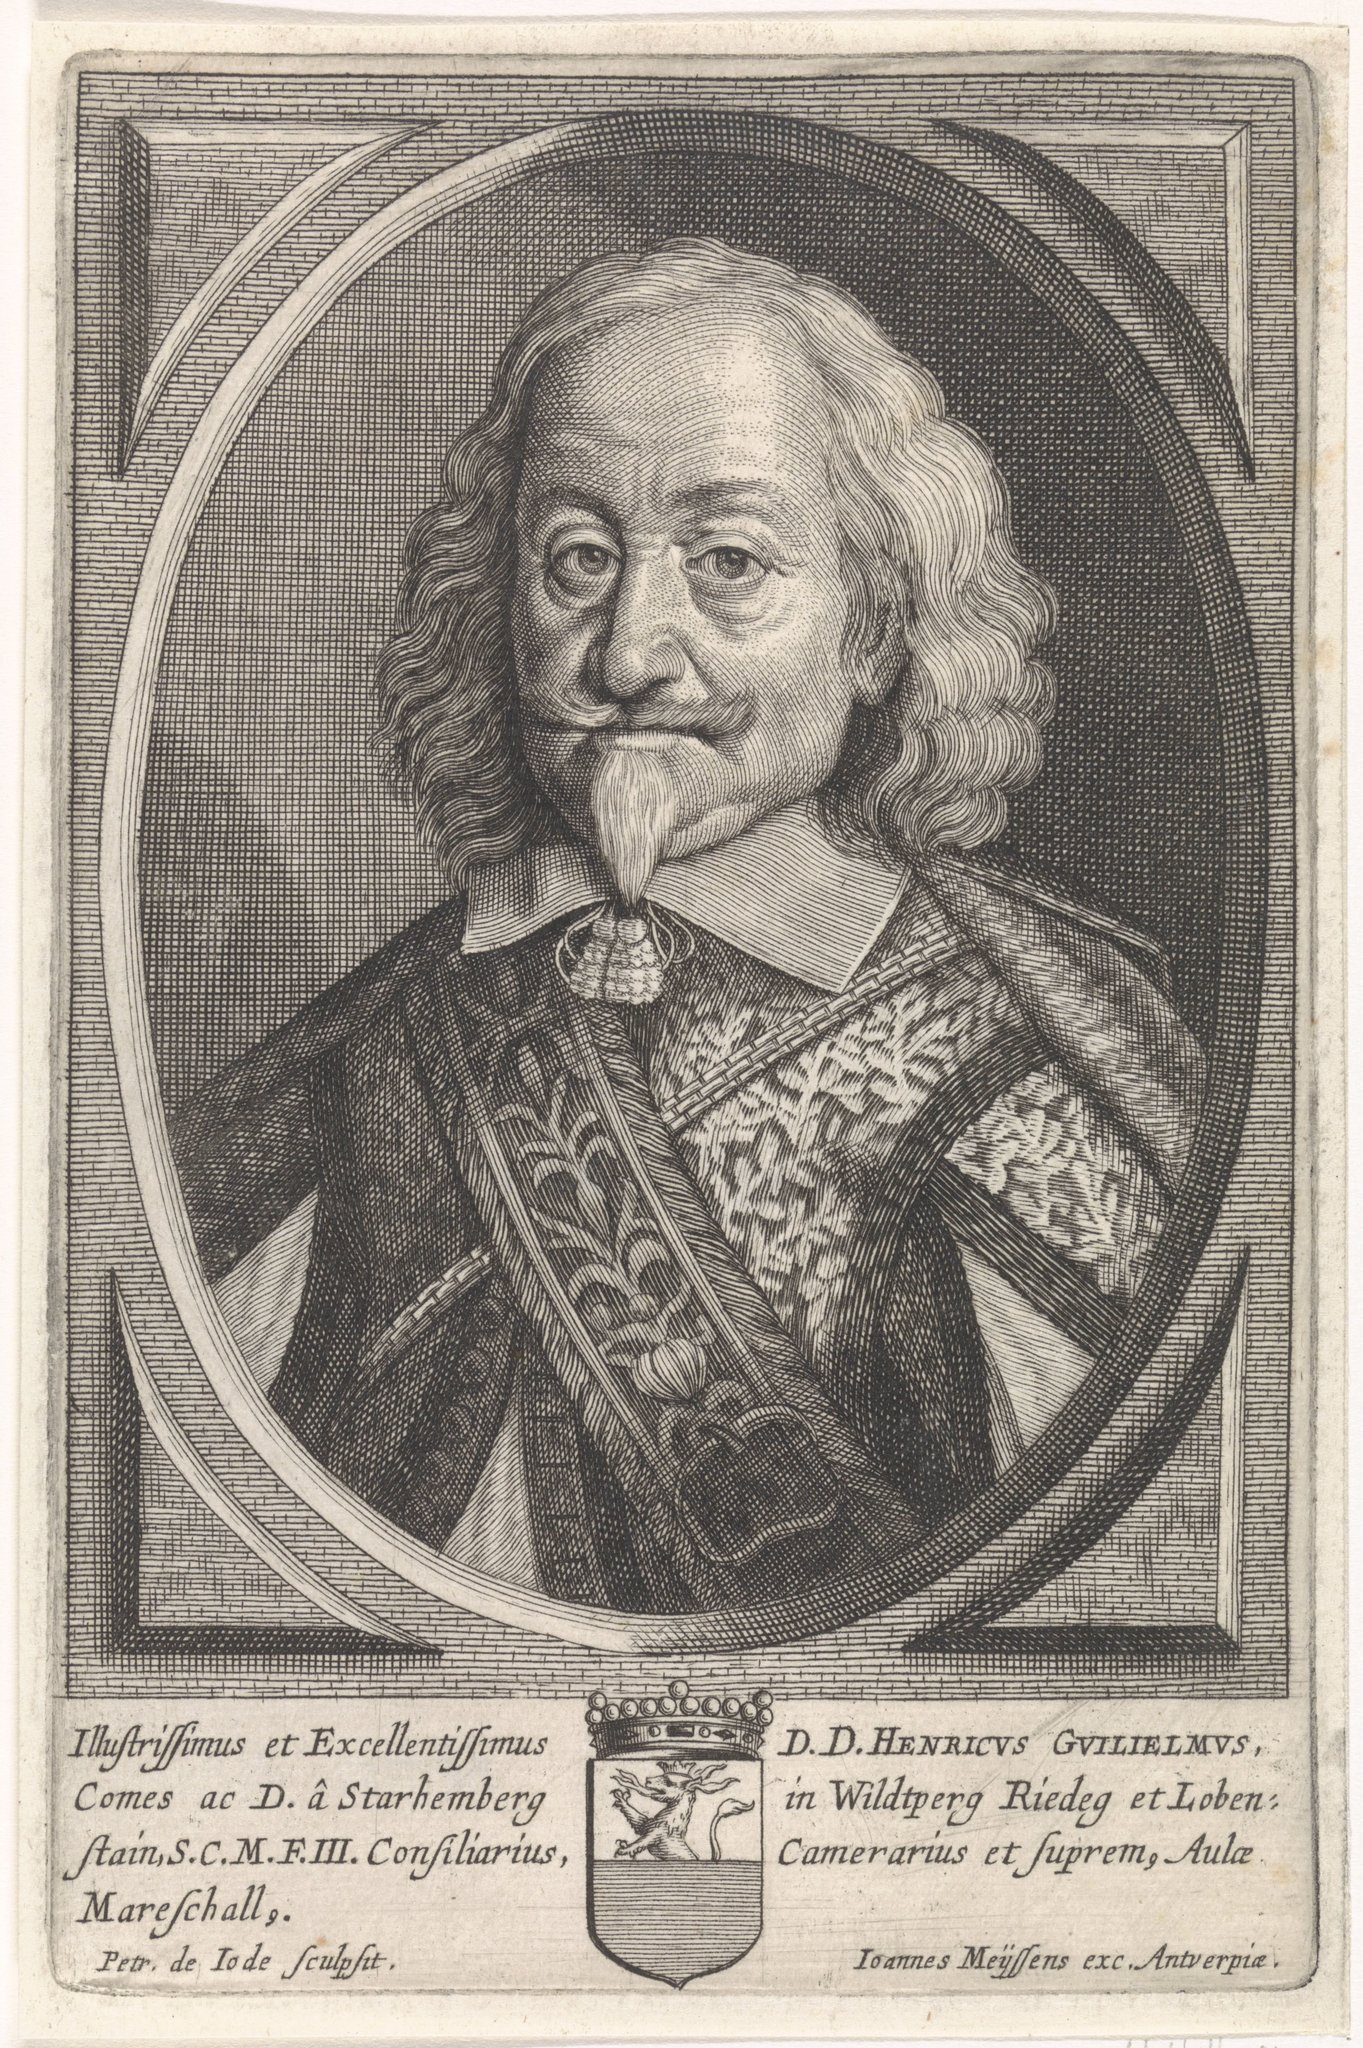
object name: print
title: Portret van Hendrik Willem van Starhemberg-Schaunberg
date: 1628-1670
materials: paper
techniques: engraving, etching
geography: antwerp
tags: vienna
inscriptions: collector's mark: Lugt 2228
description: Busteportret van Hendrik Willem van Starhemberg-Schaunberg, graaf van Oostenrijk. Het portret is gevat in een ovale omlijsting met vierkant randwerk. In de marge zijn wapenschild en een vierregelig onderschrift in het Latijn.